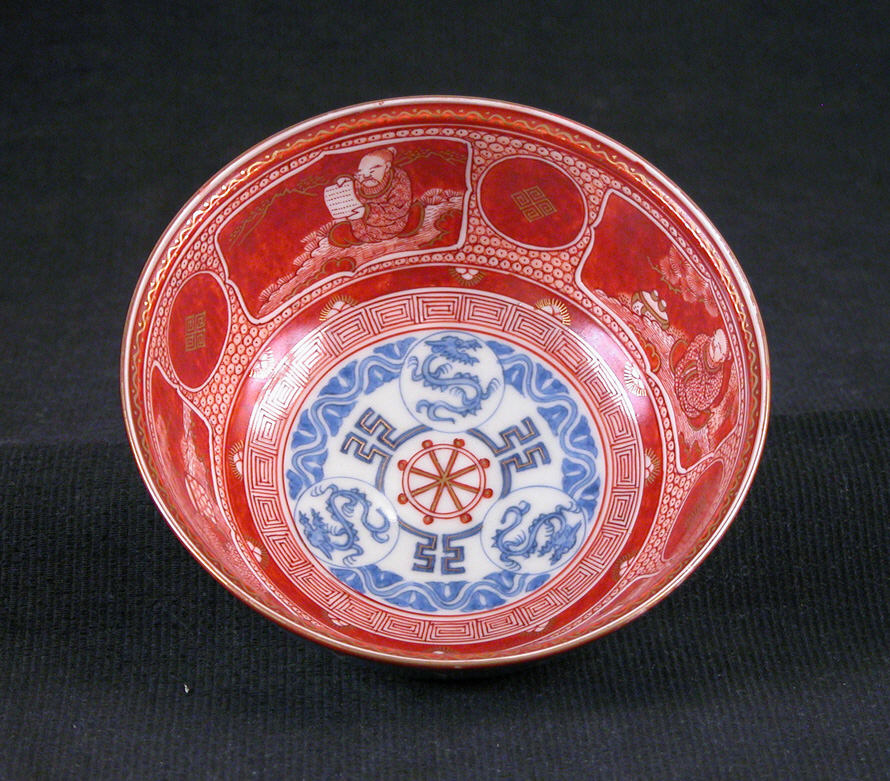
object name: bowl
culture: japanese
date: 1850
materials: enamel, glaze, porcelain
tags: men,dragons